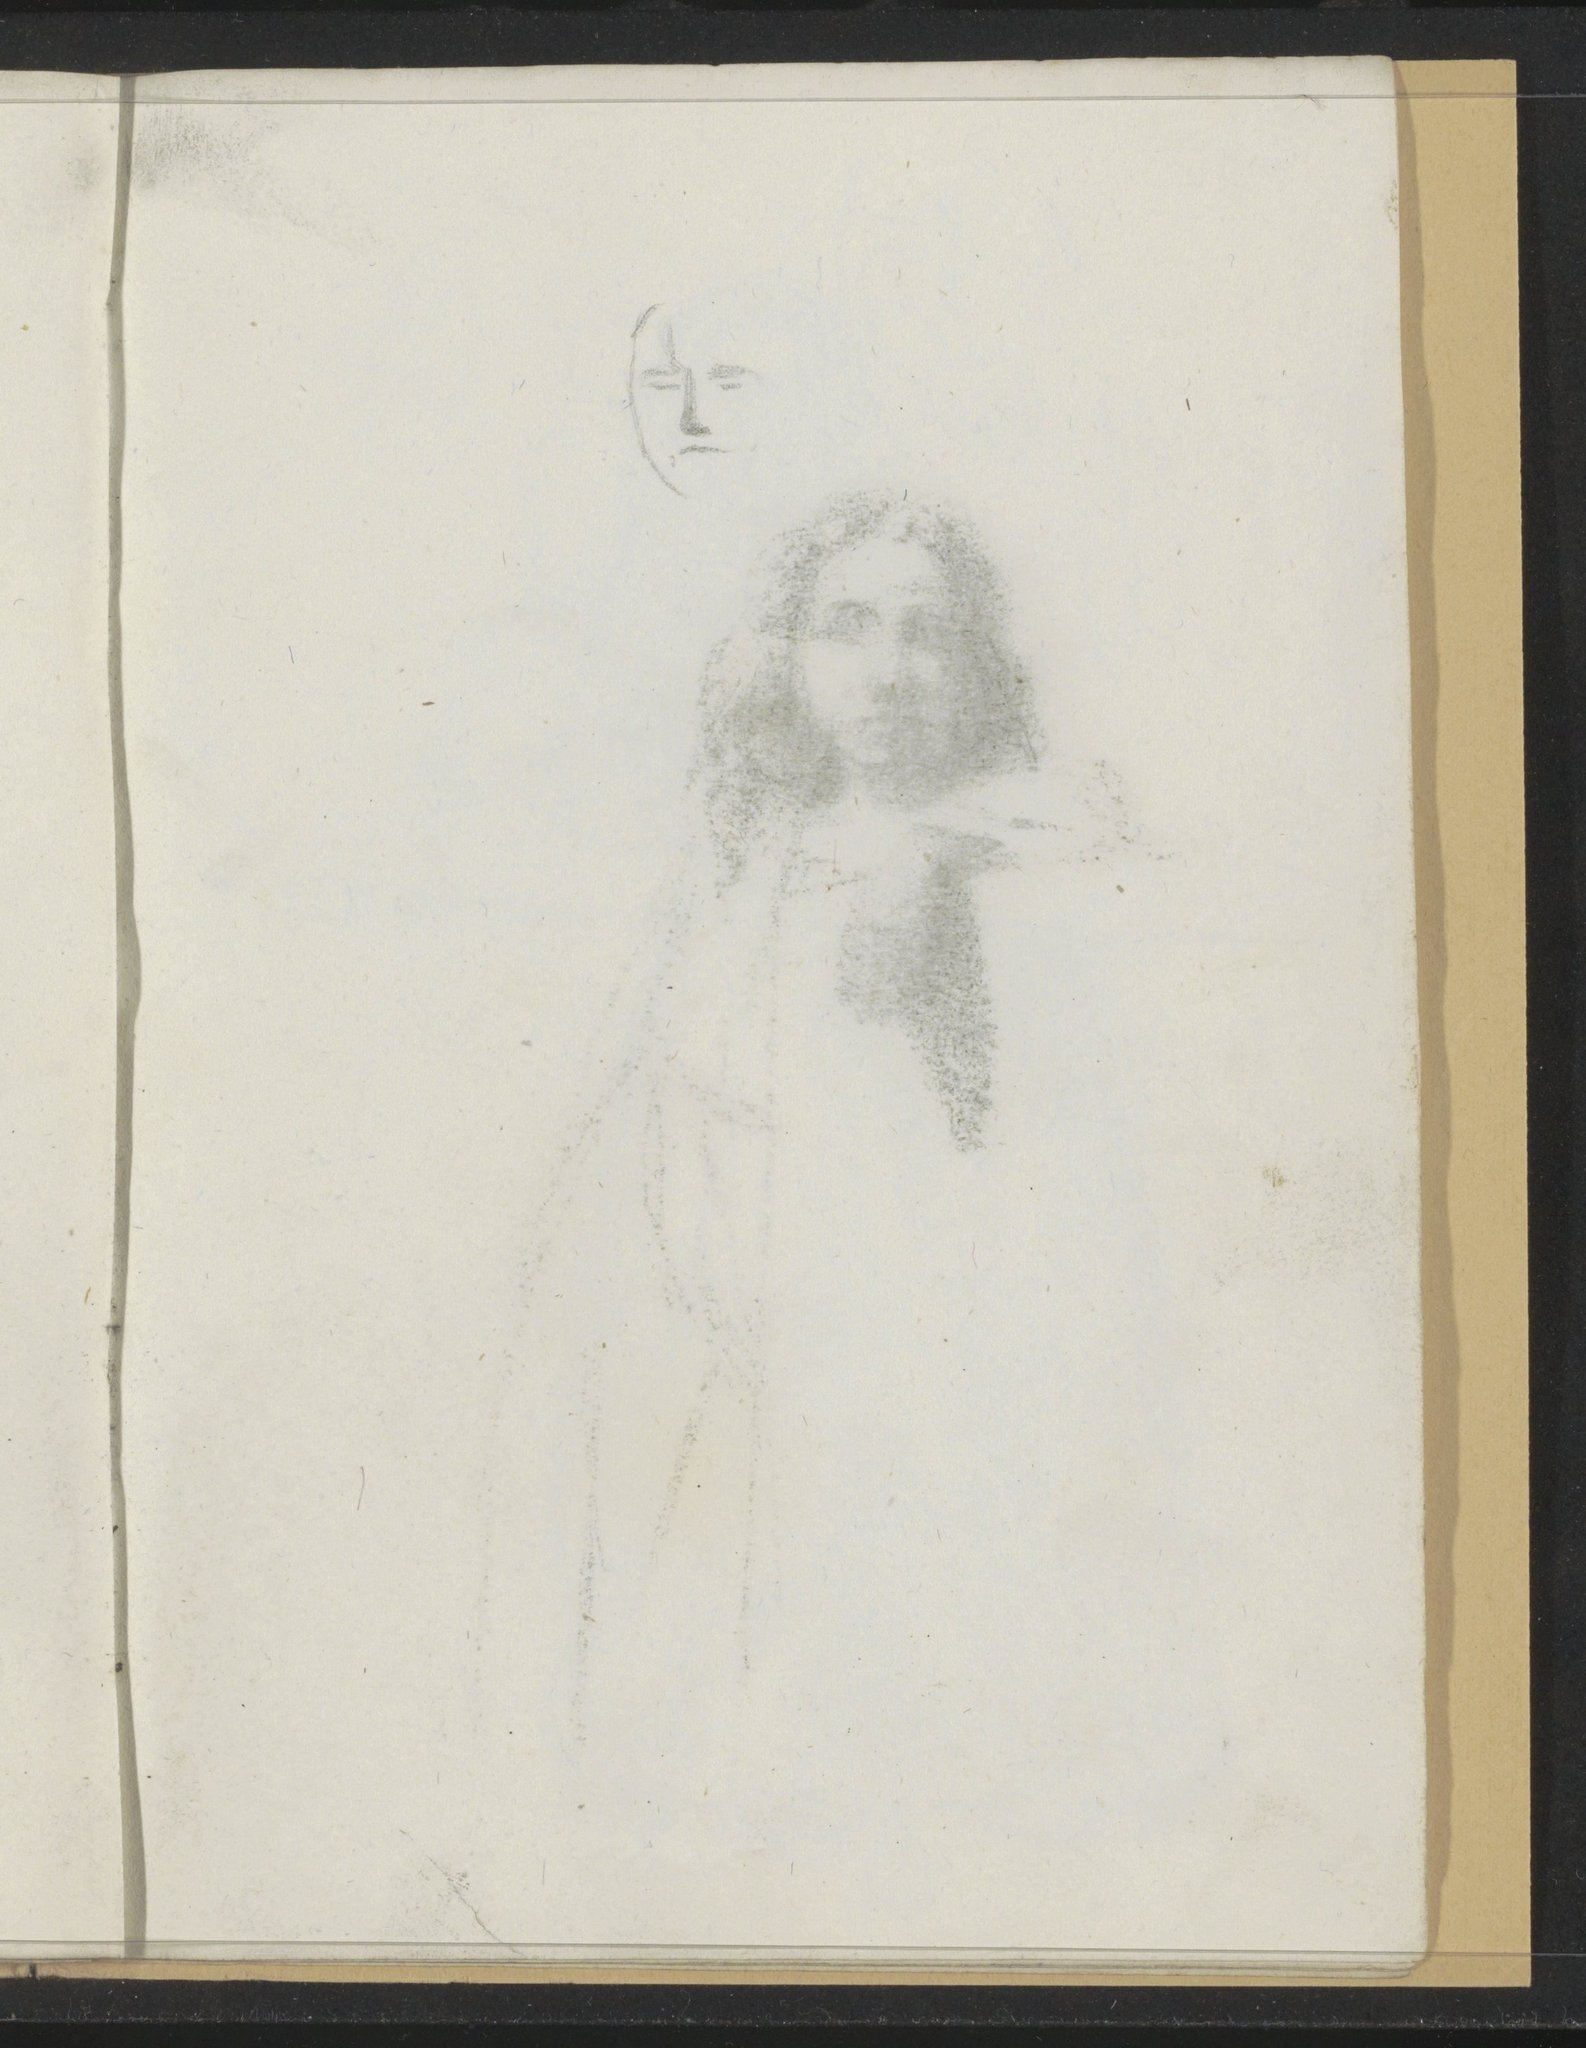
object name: sketchbook leaf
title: Gezicht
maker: jozef israëls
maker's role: draughtsman, painter, print maker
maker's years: 1824-1911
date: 1834-1911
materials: paper, pencil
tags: face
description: Blad 13 recto uit een schetsboek met 16 bladen.